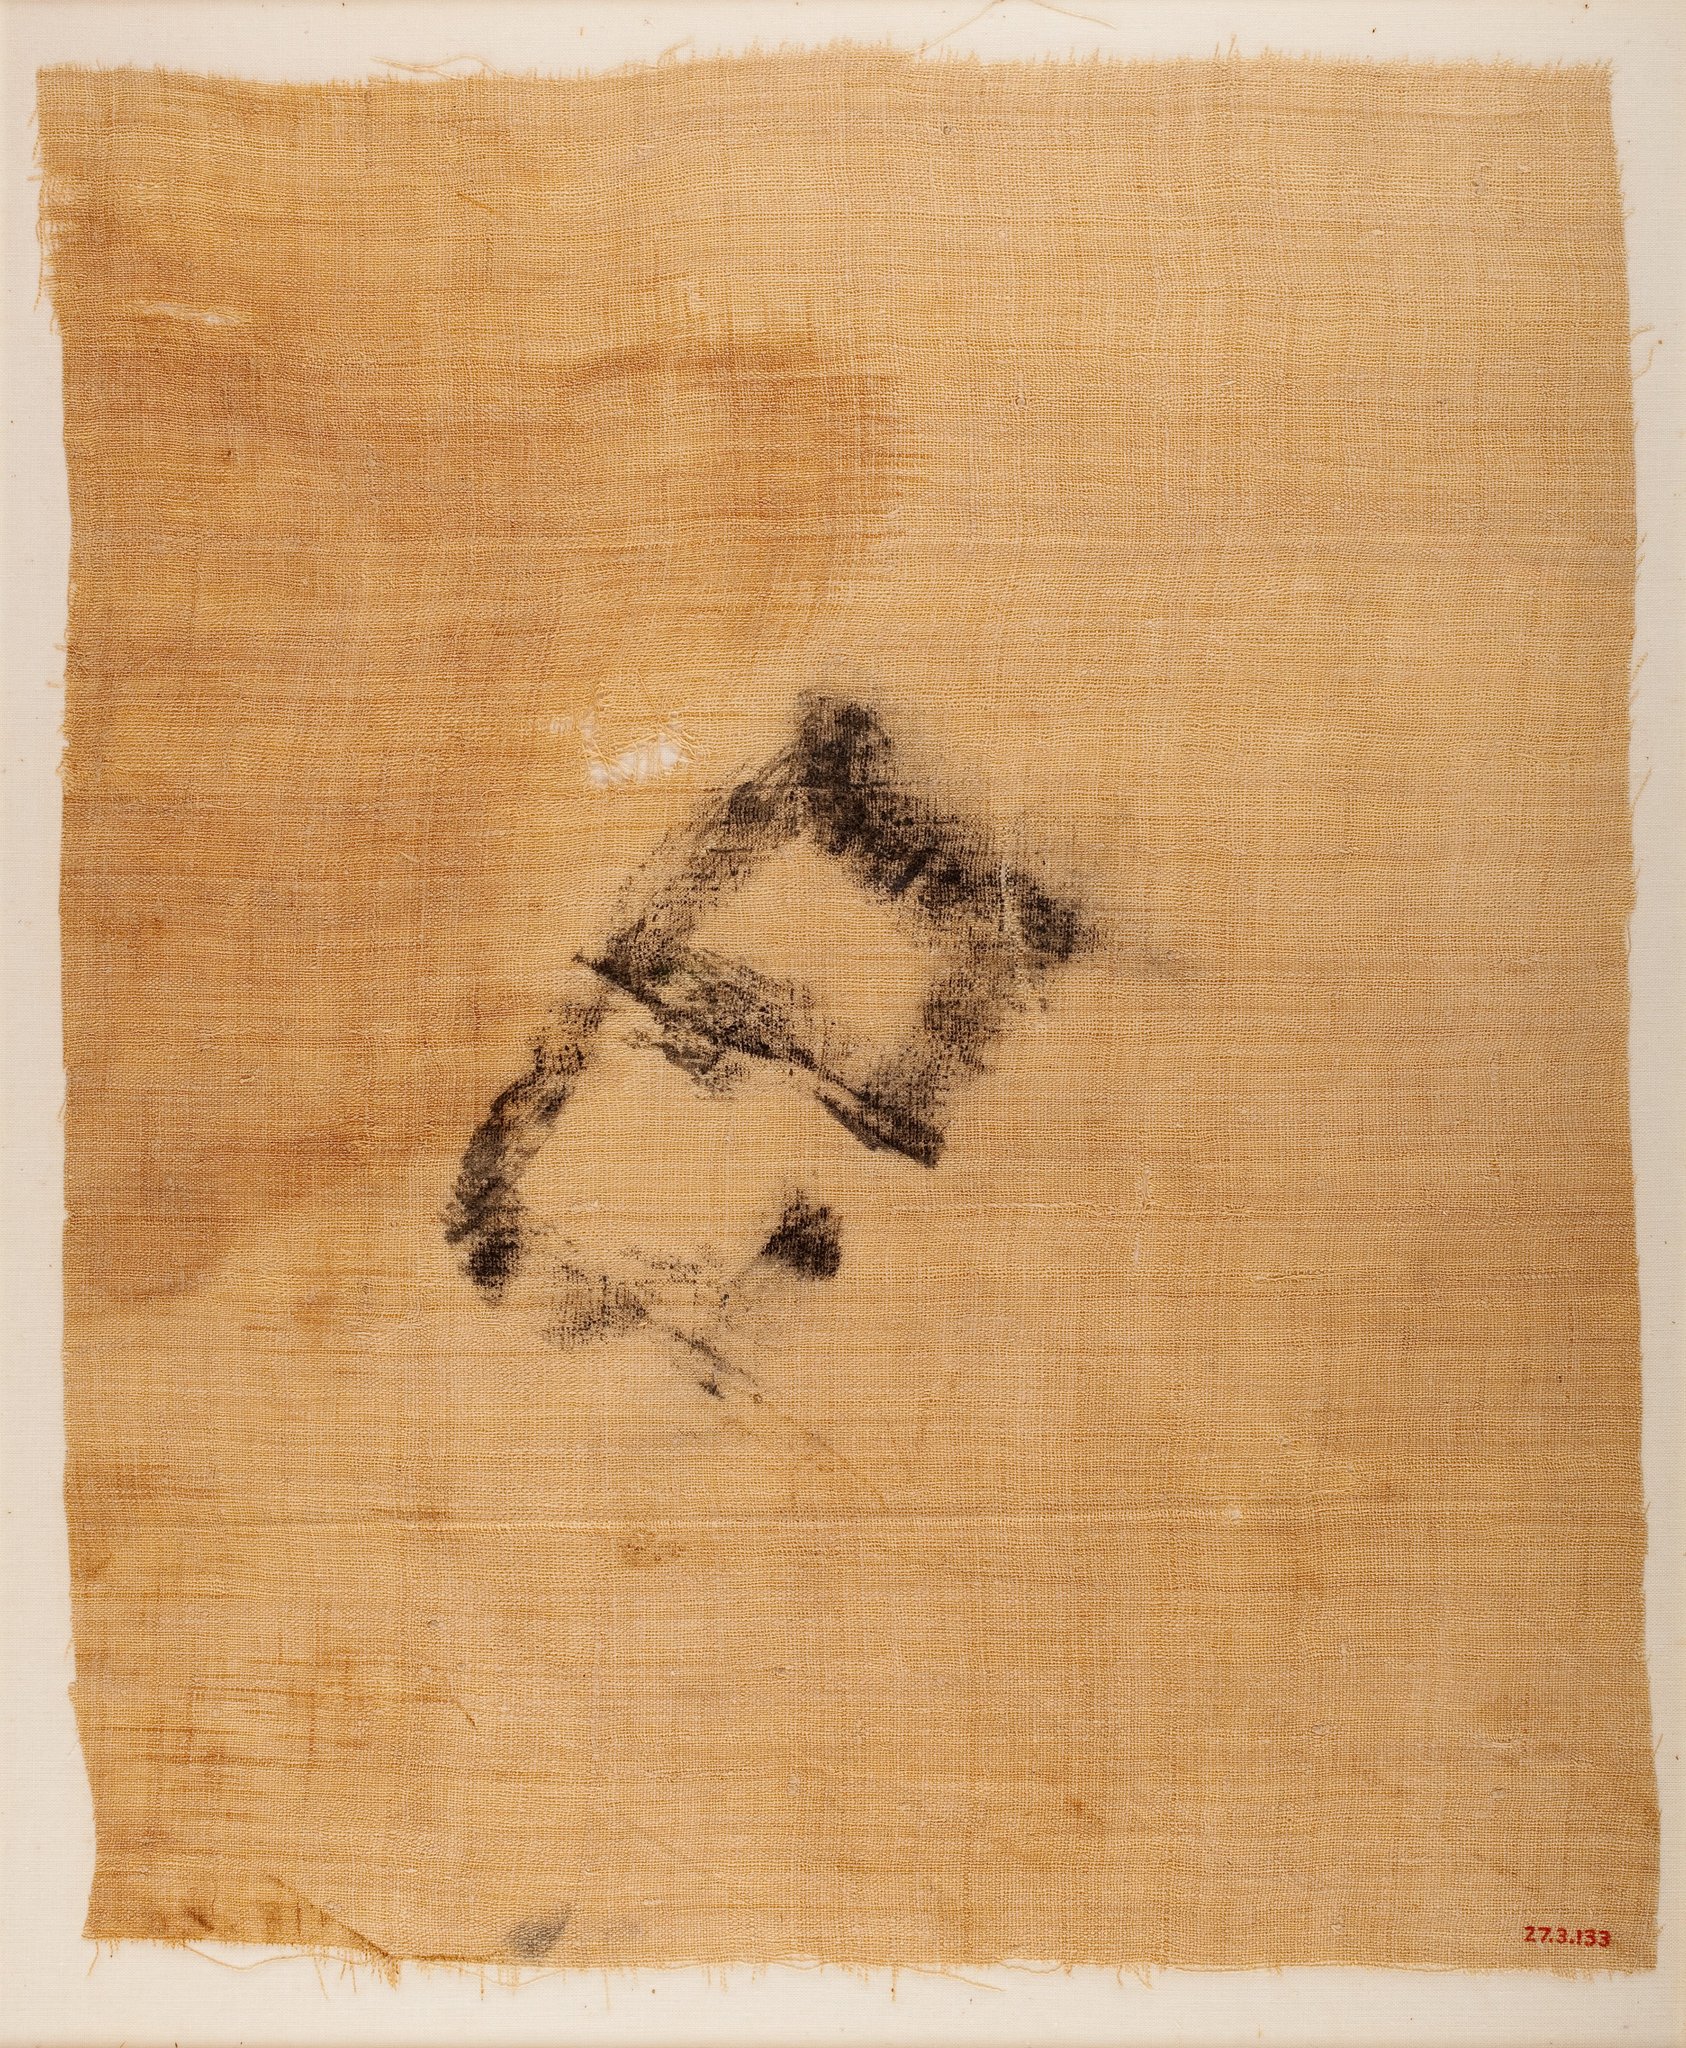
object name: linen mark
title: Linen mark (Type XXXVI)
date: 1961-1917 BCE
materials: linen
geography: egypt